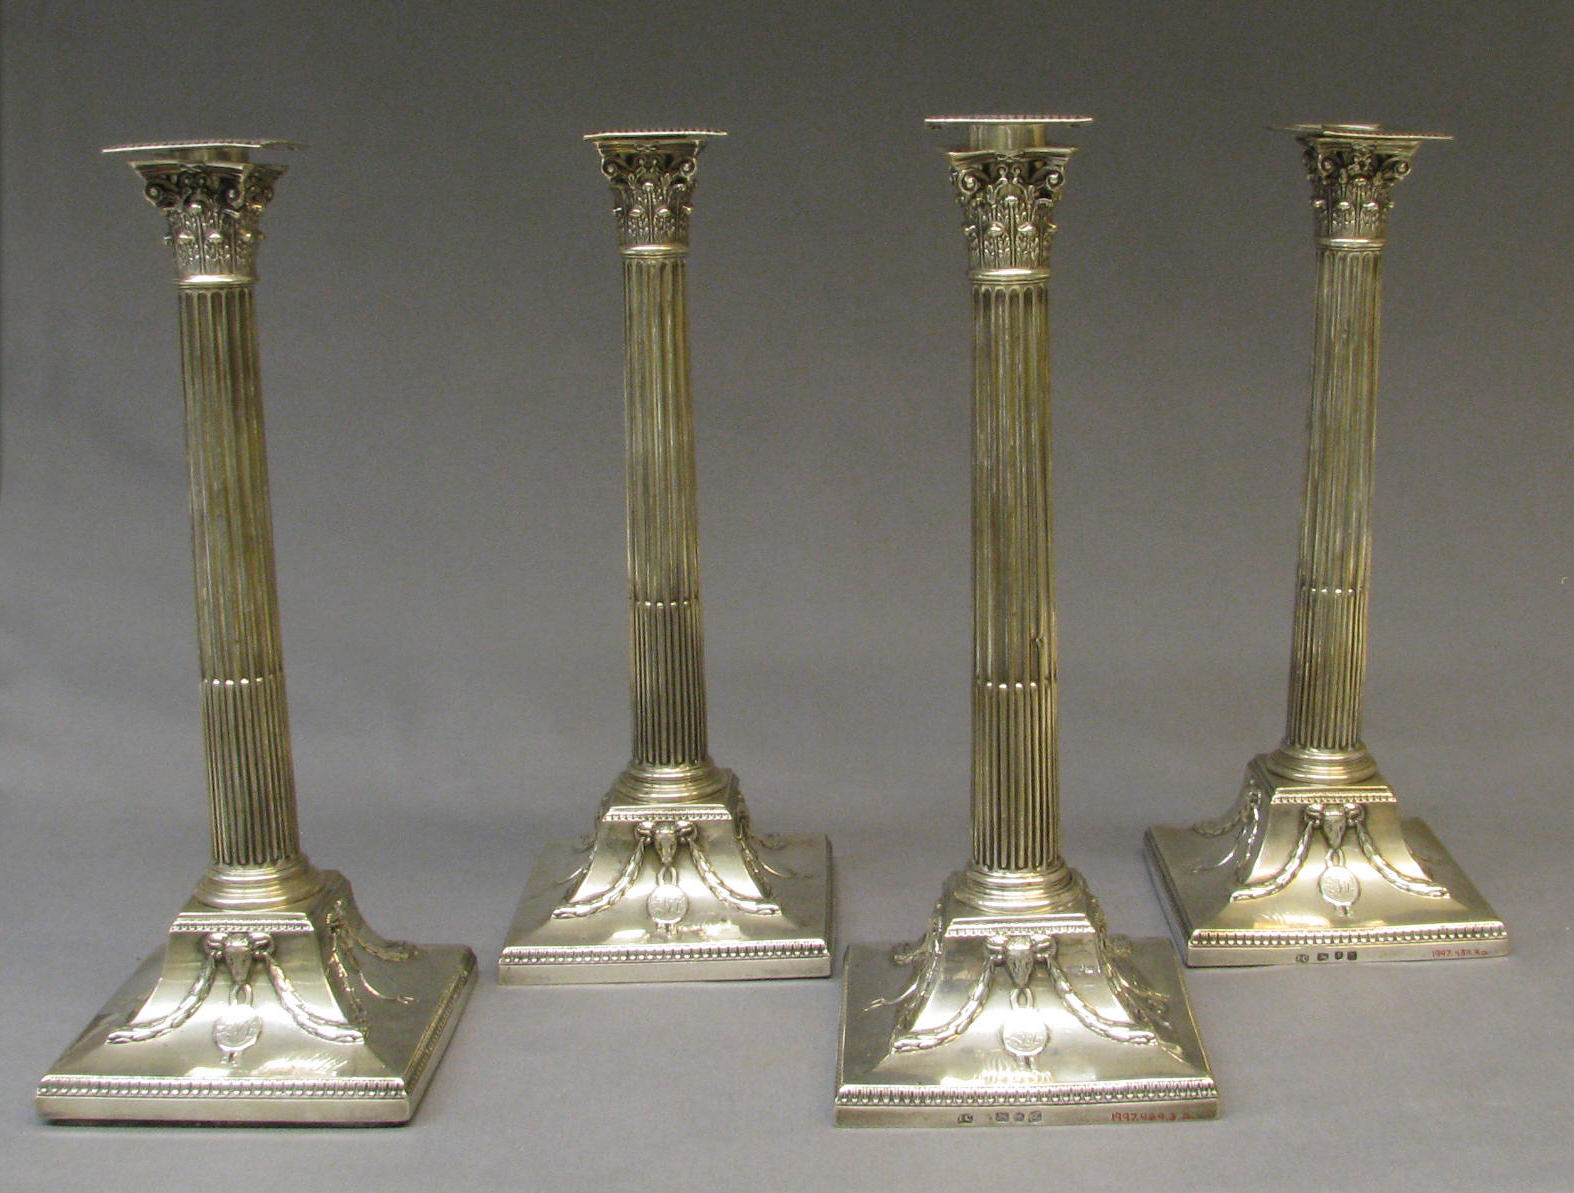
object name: candlestick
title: Four candlesticks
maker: john carter ii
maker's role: maker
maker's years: 1768-1777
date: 1774-1775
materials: silver